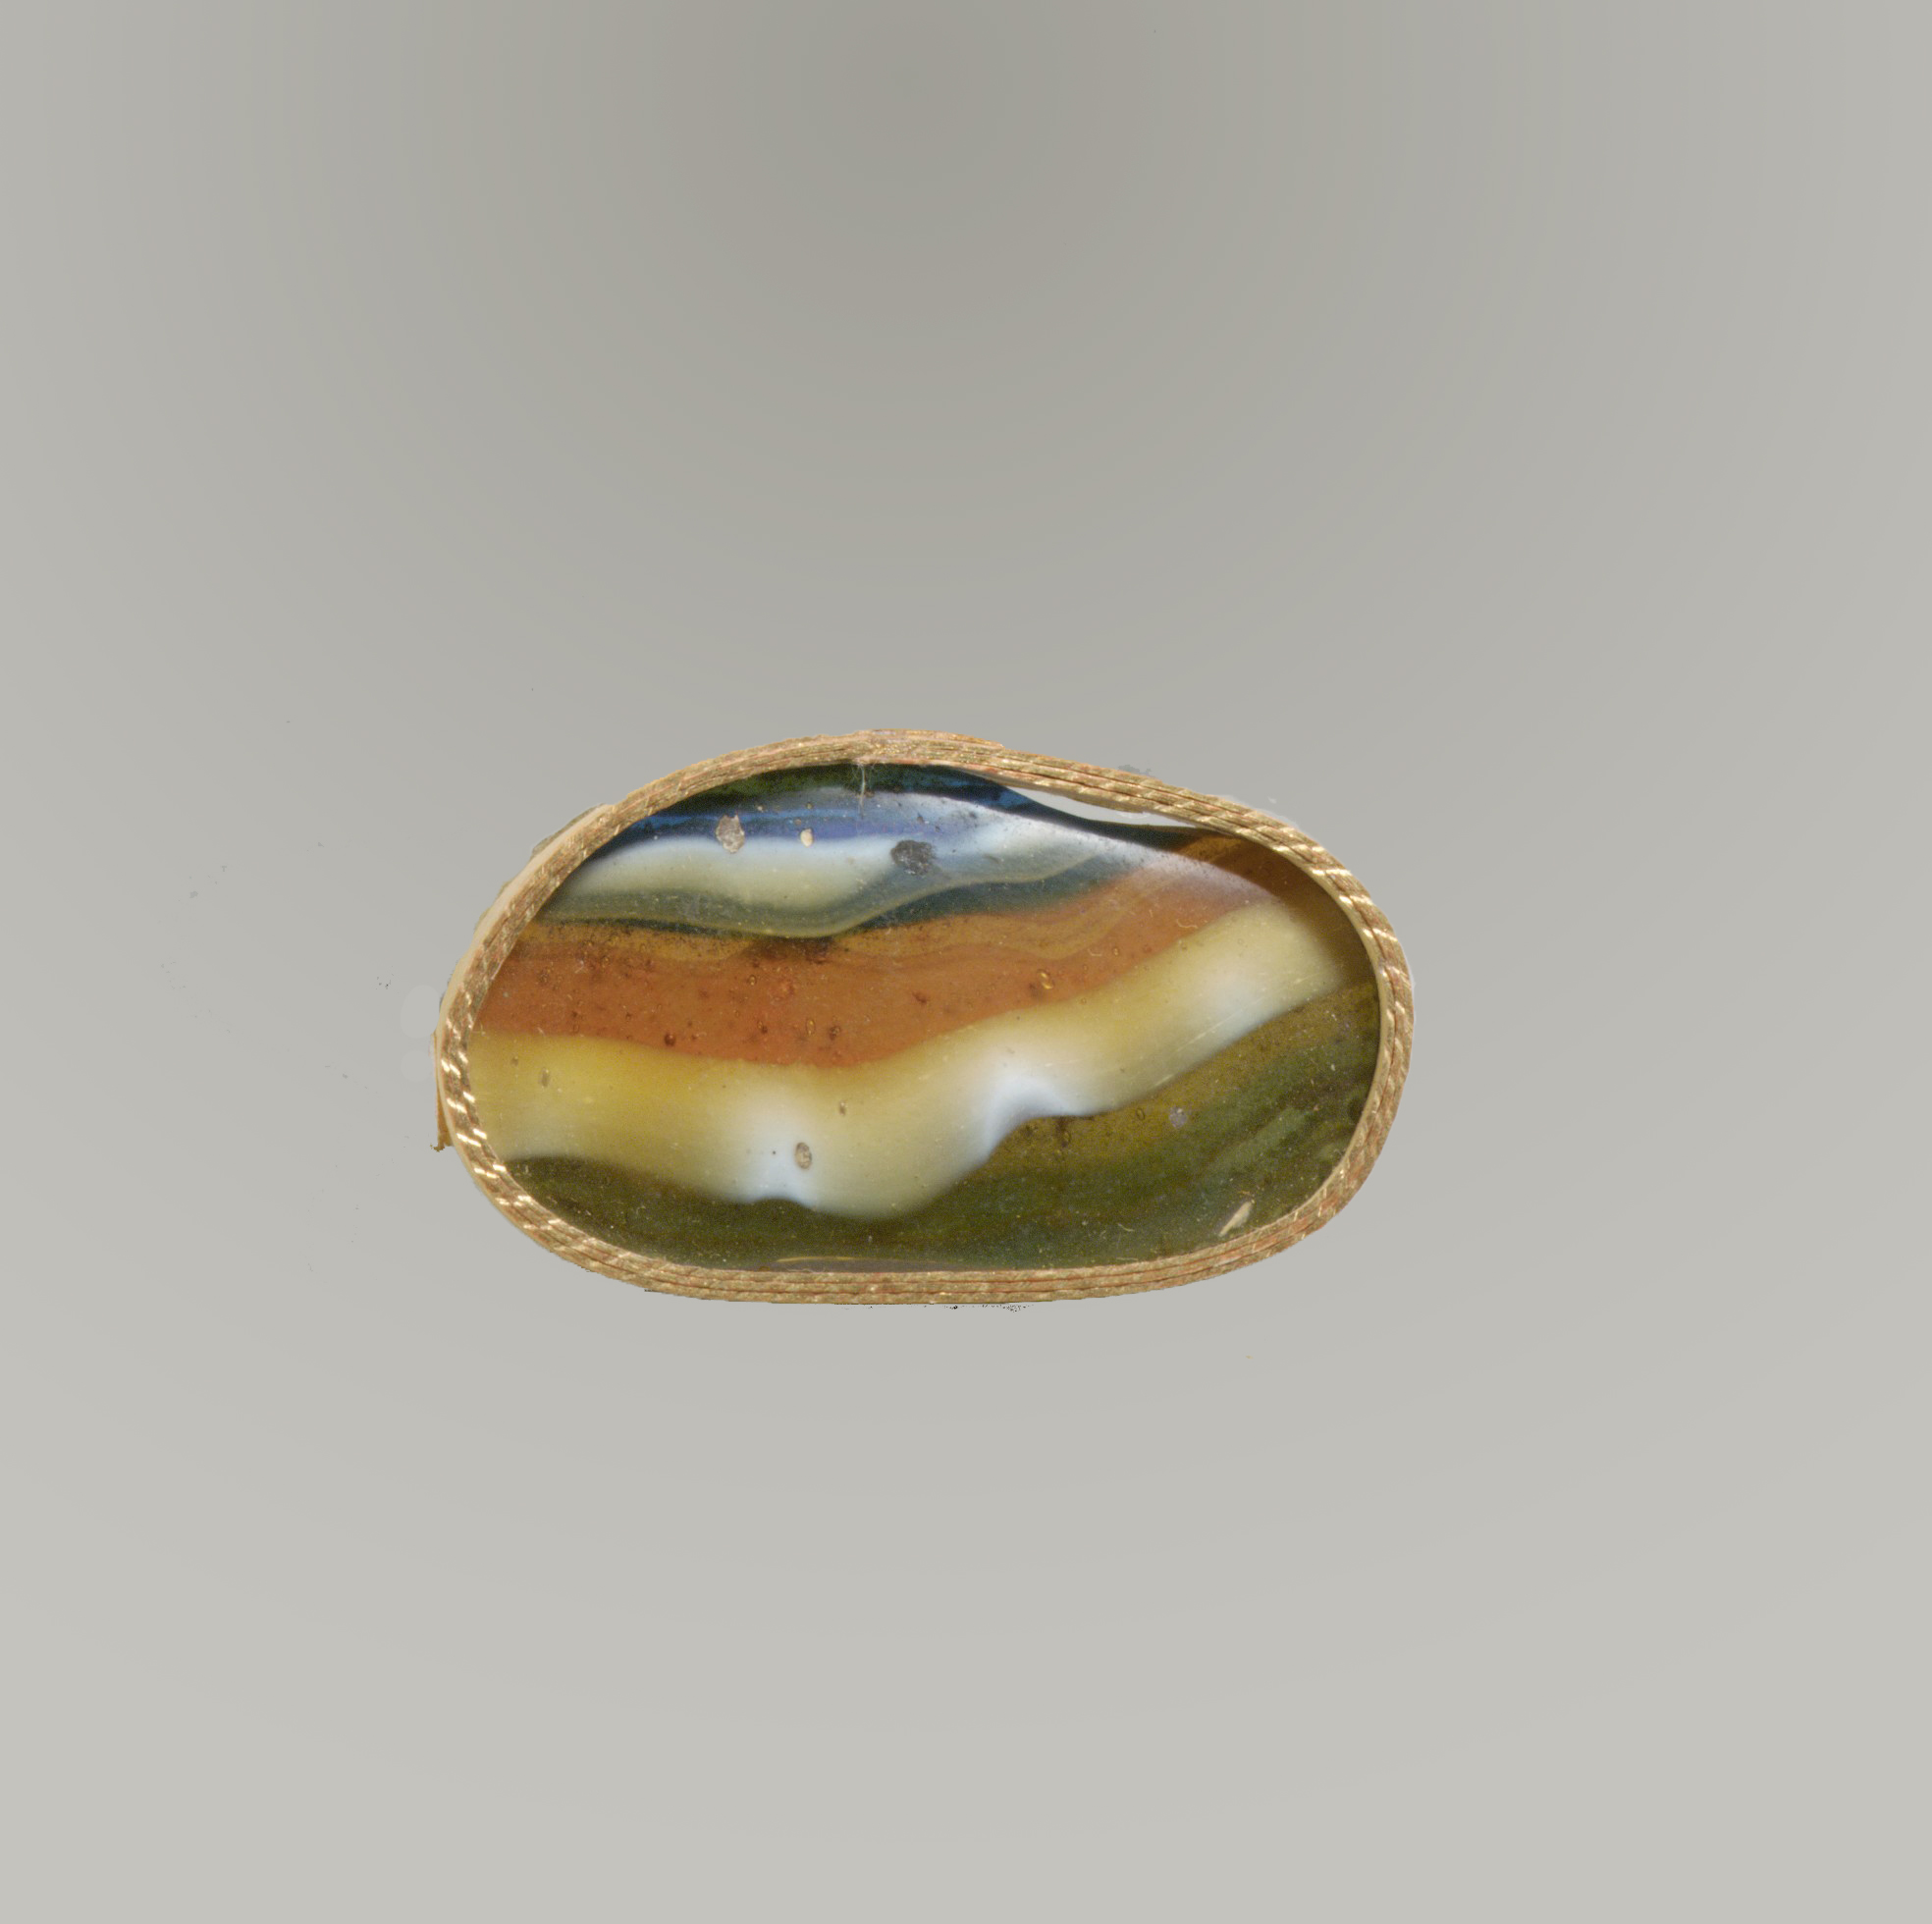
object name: fragment, mosaic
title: Glass mosaic bowl fragment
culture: roman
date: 34 BCE-33 CE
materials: glass